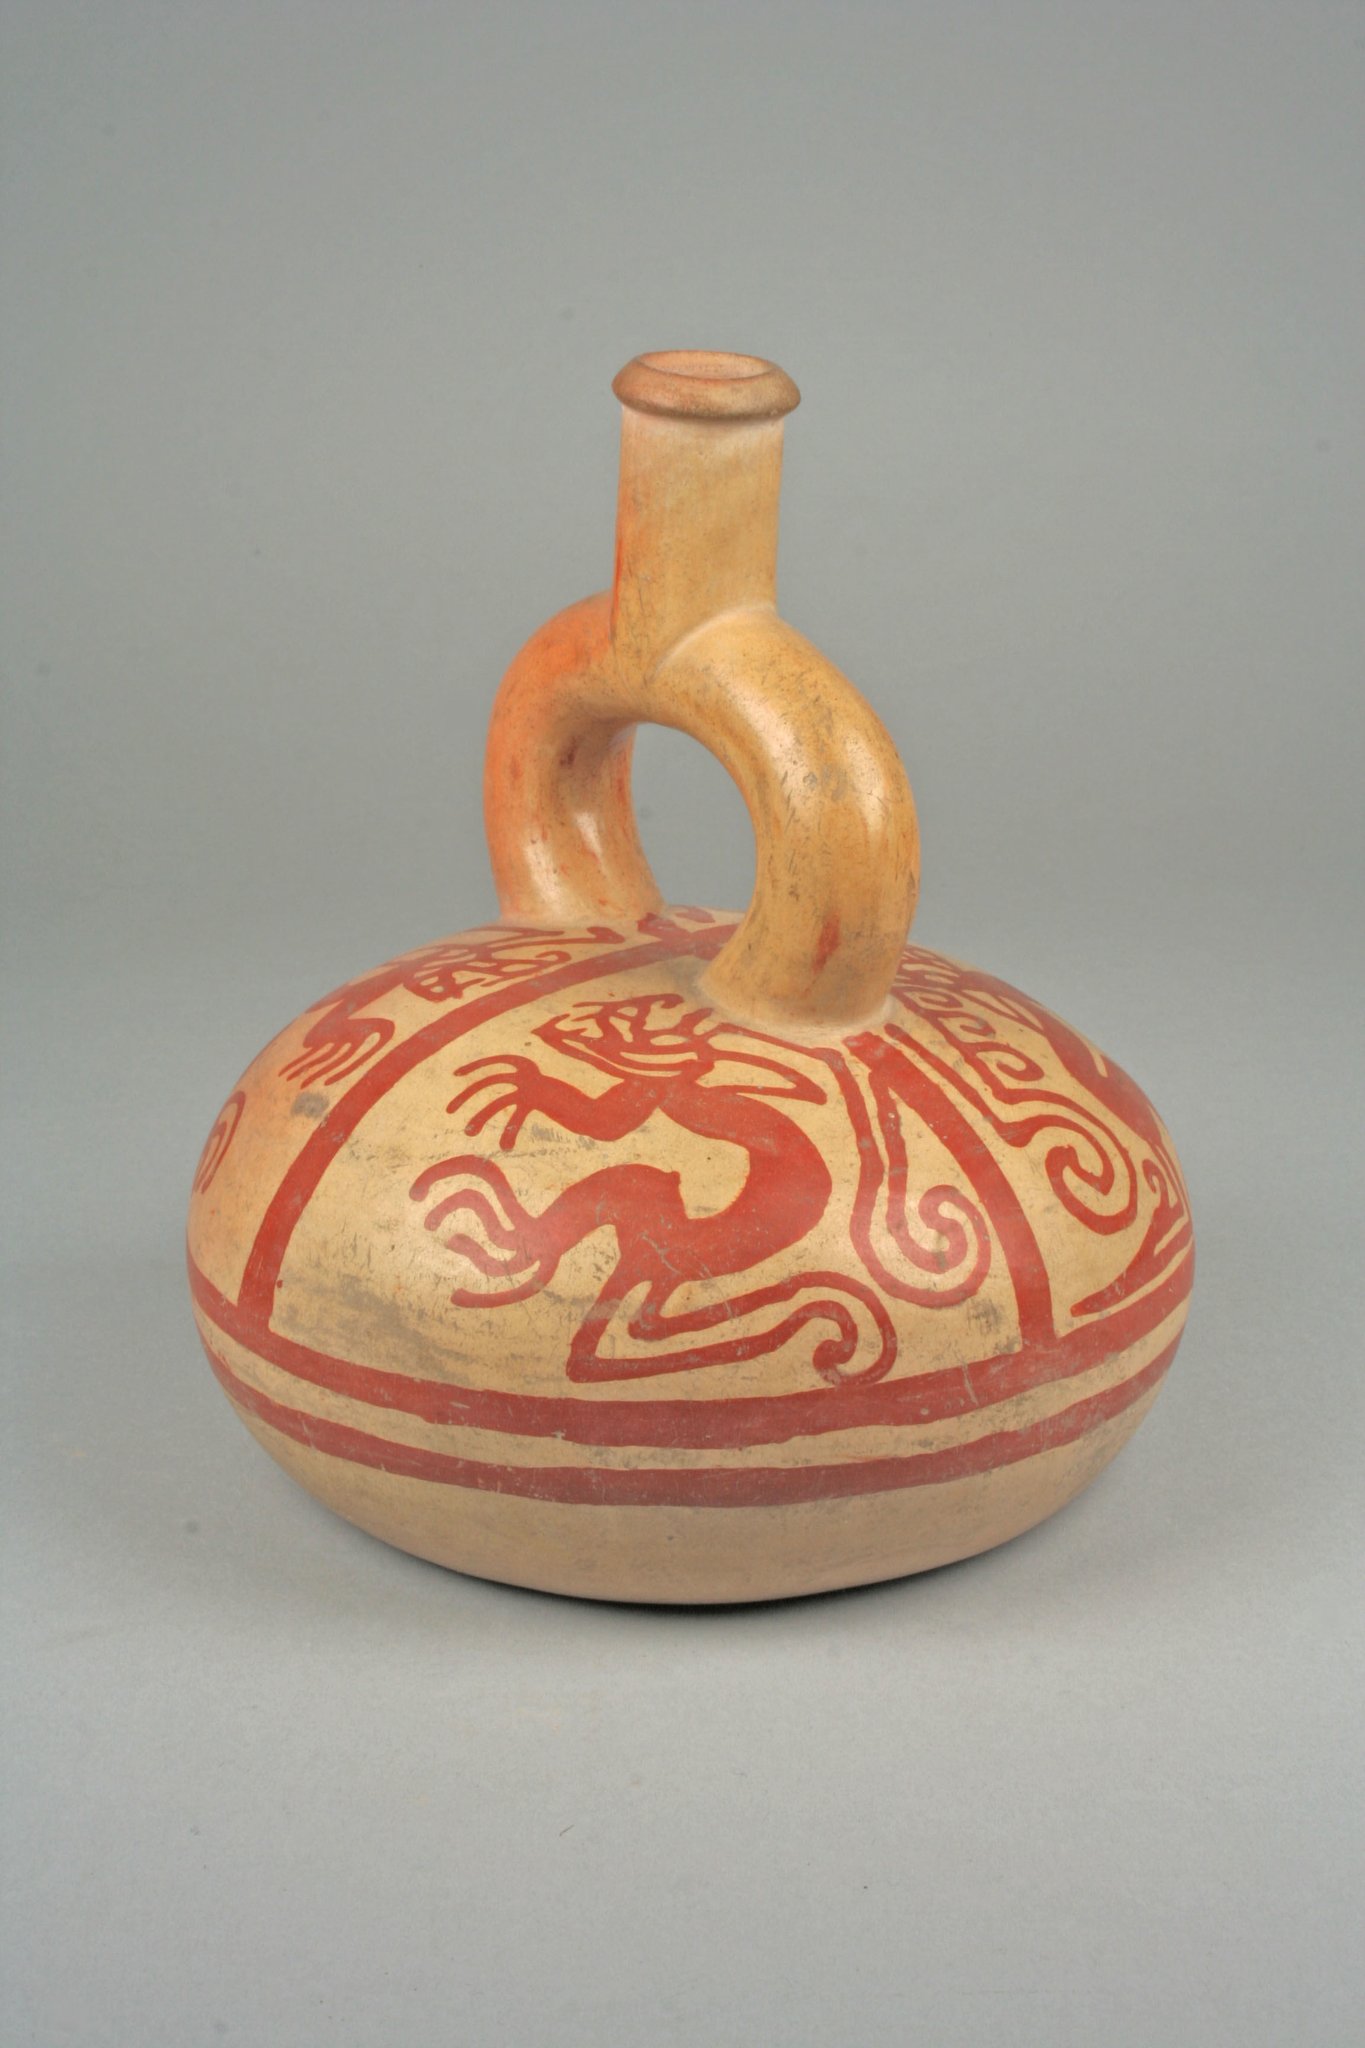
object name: bottle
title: Stirrup Spout Bottle with Pumas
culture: moche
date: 300-150 BCE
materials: ceramic, pigment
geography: peru